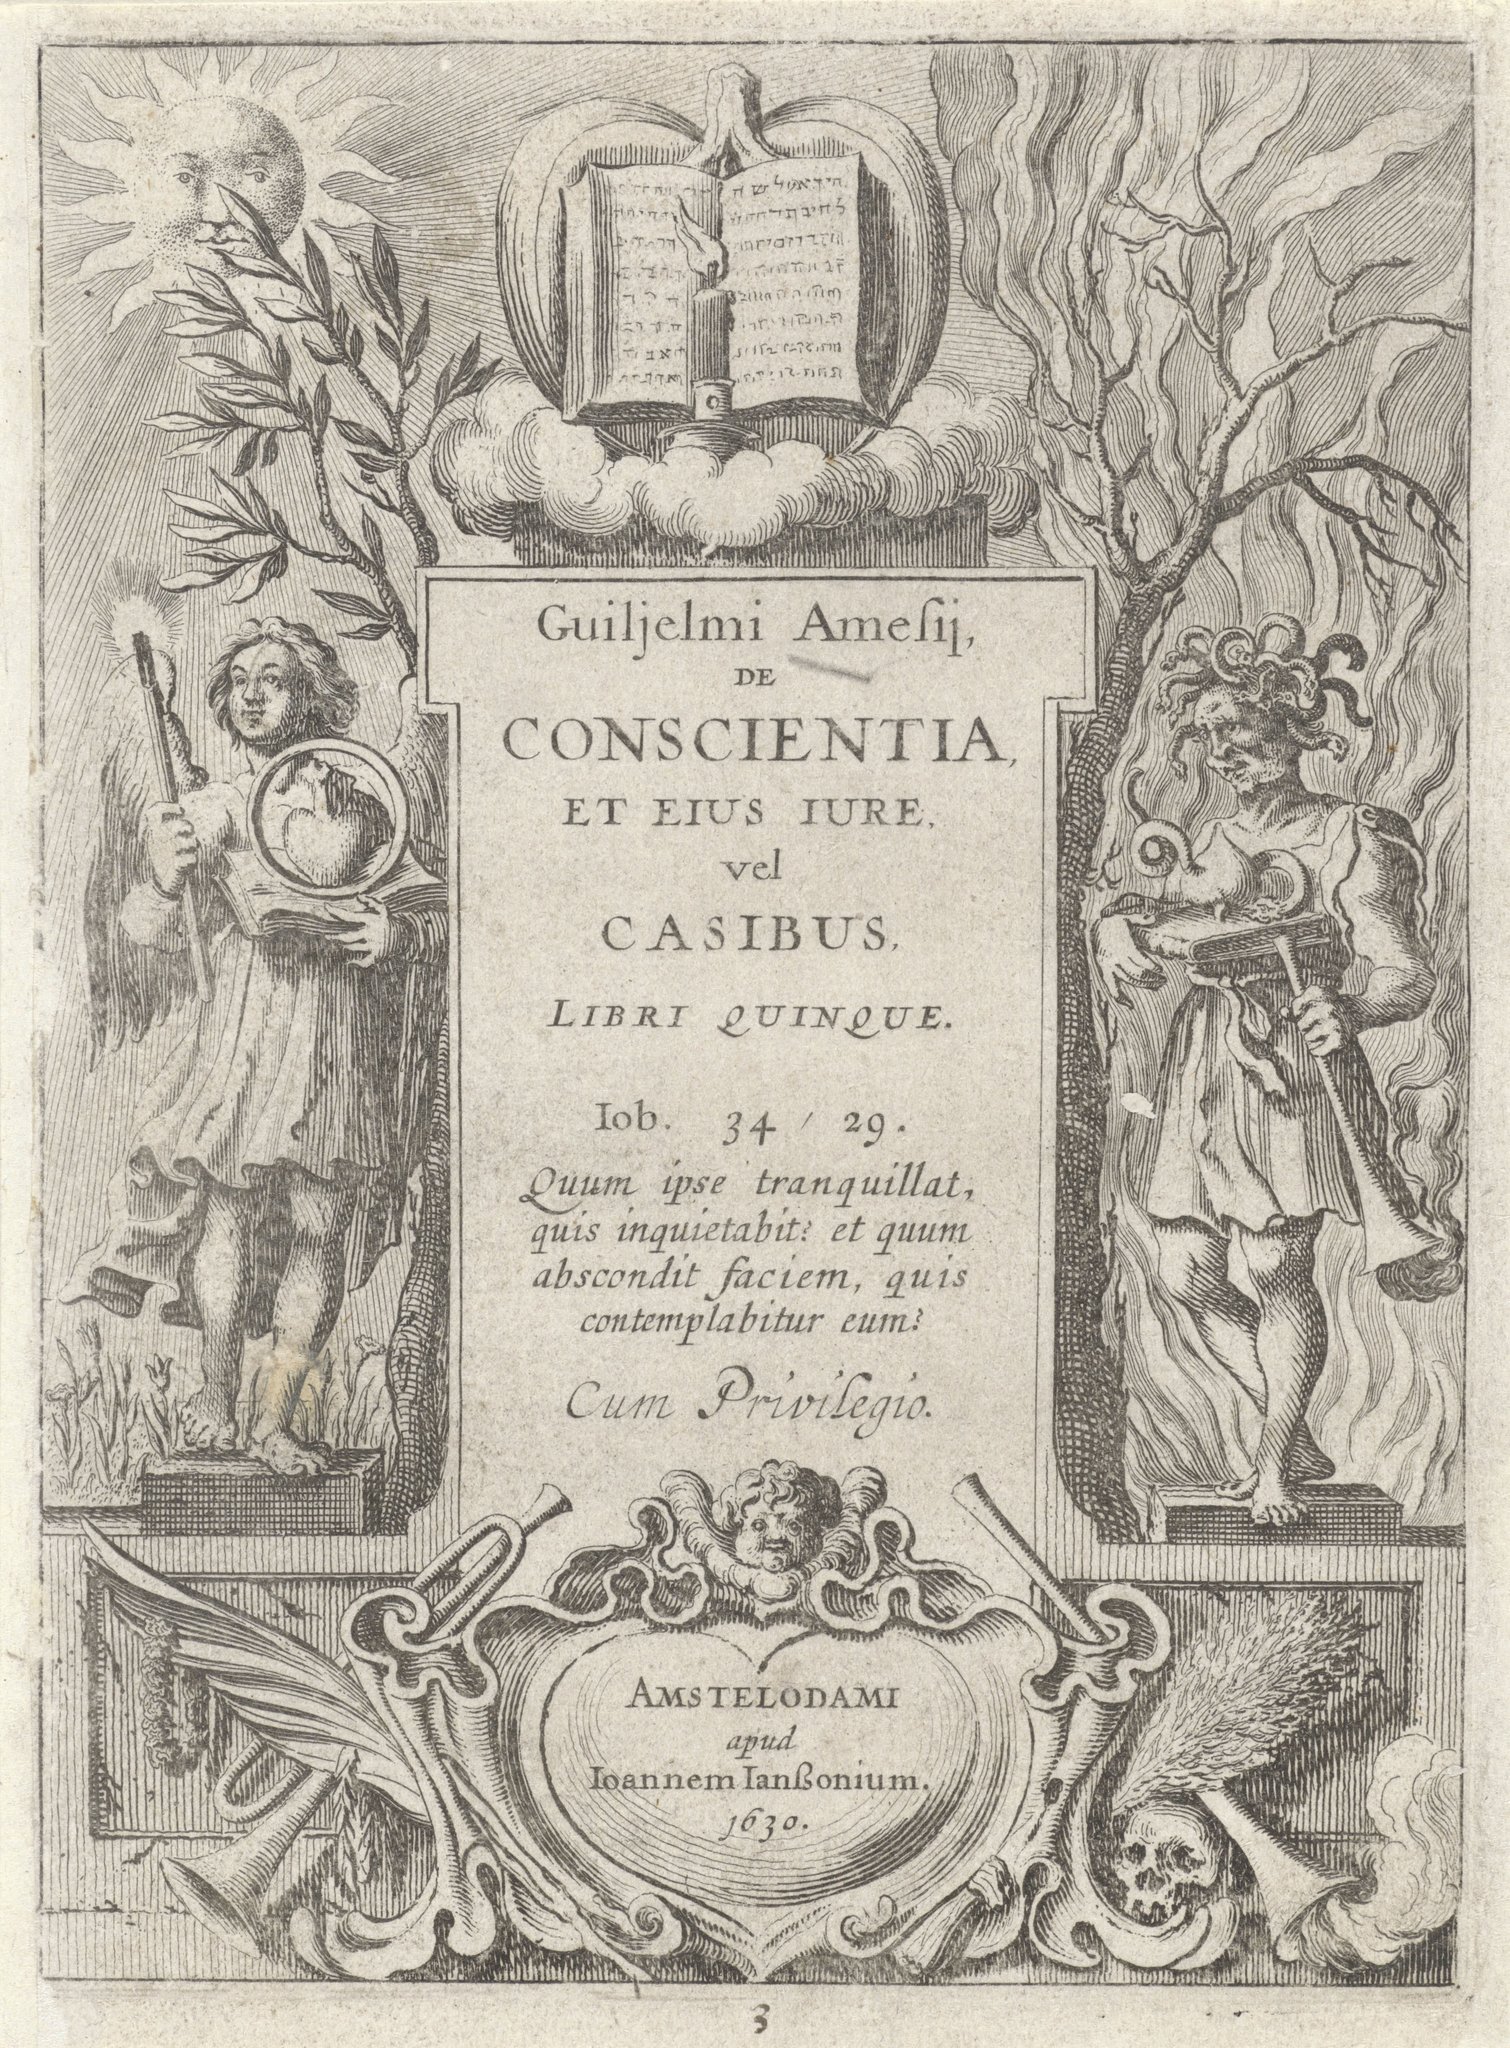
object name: print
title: Titelblad voor Willem Ames, De Conscientia, 1630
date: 1630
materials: paper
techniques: engraving, etching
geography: haarlem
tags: bible, devil(s) and demons, angels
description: Titelblad voor Willem Ames "De Conscientia", 1630. De titel wordt geflankeerd door een engel en een duivels figuur. De engel draagt in de hand een fakkel (symbool voor de waarheid) en een hart in een cirkel; symbool voor eeuwige liefde. Boven haar straalt de zon en naast haar groeit een olijfboom (het symbool voor vrede). De duivelse figuur staat naast een kale boom, te midden van een vlammenzee. Boven de titel de bijbel, verlicht door kaarslicht.